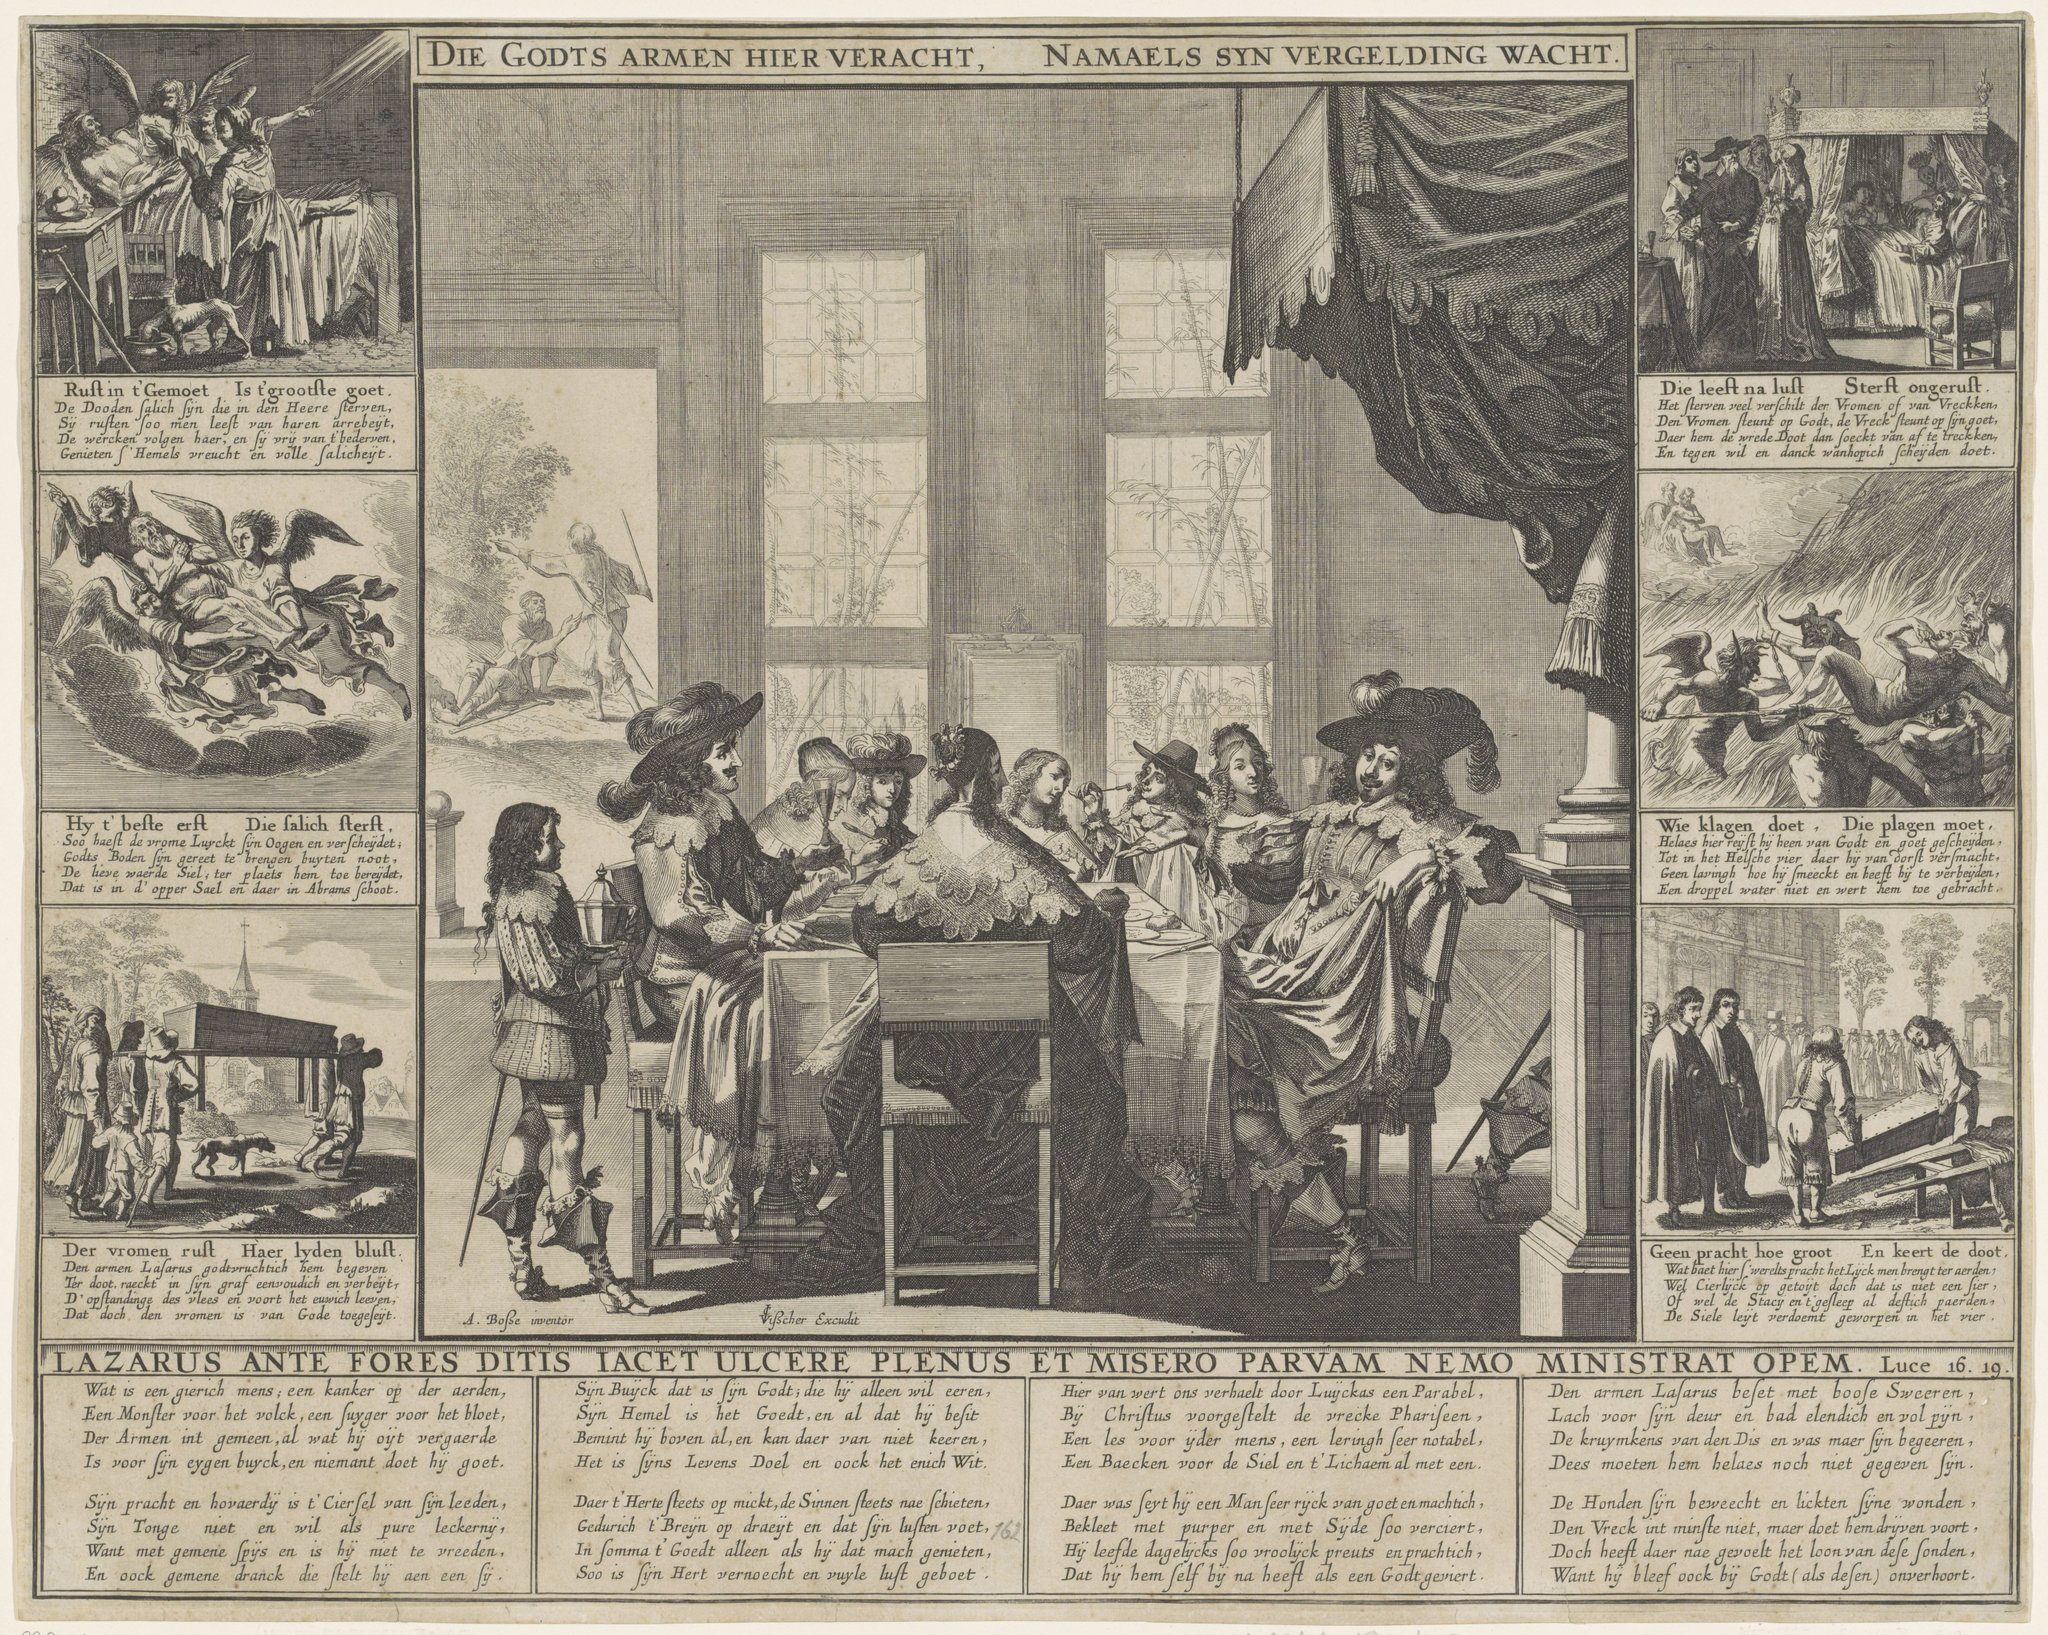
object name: print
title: Lazarus en de rijke man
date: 1630-1652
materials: paper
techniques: engraving, etching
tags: lazarus dies: his soul is carried into abraham's lap by angels, dives dies; his soul is brought into hell by devils, in hell dives sees lazarus in paradise; usually dives pointing at his tongue, the rich man (dives) is feasting, while poor lazarus is starving at the gate (dogs licking lazarus' sores) (luke 16:19-31)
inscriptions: collector's mark: Lugt 2228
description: De Amsterdamse uitgever Claes Jansz. Visscher (II) produceerde vanaf de jaren ’30 van de zeventiende eeuw grote Bijbelse prenten op zogenaamd royaal-formaat papier (ca. 480 x 580 mm). Na zijn dood in 1652 zette zijn zoon Nicolaes Visscher (I) het bedrijf voort en zo ook de uitgave van Royaalbijbelprenten. Toen Nicolaes in 1679 overleed nam zijn zoon Nicolaes Visscher (II) het bedrijf over en gaf kort hierna, omstreeks 1680, een fondslijst uit. Hierin worden 130 prenten met Bijbelse voorstellingen op royaalpapier beschreven (zie documentatie J. van der Waals). Complete prentbijbels op royaal-formaat werden door vader en zoon Nicolaes Visscher uitgegeven onder de titel Historiae Sacrae Veteris et Novi Testamenti. De bladen werden echter ook los verkocht en konden worden gecombineerd met Royaalbijbel-prenten van andere uitgevers. Verschillende Amsterdamse uitgevers brachten namelijk ook bijbelprenten op royaal-formaat uit, onder wie Clement de Jonghe en Cornelis Danckerts. De door de firma Visscher uitgegeven prenten zijn veelal vervaardigd door anonieme prentmakers naar voorbeeld van verschillende zestiende- en zeventiende-eeuwse Bijbelse prenten en prentreeksen. Veelal moesten de composities worden aangepast aan het grotere en langgerekte royaal-formaat. Daarnaast zijn er ook grote bladen van bekende prentmakers zoals Jan van Londerseel, Pieter Nolpe, Jacques de Gheyn (II) en Jan Harmensz. Muller opgenomen in de categorie ‘Bybelsche Figuren, op Royaal-bladen’ in de fondslijst van Visscher. Prent mogelijk gebruikt in: Historiae Sacrae Veteris et Novi Testamenti (Royaalbijbel). Amsterdam: Nicolaes Visscher (I) en (II), [1652-1702]. In de fondslijst van Nicolaes Visscher II (ca. 1680) is het onderwerp van deze prent onder de titel 'Bybelsche Figuren, op Royaal-bladen. bestaande uyt de volgende historien.' als volgt genummerd: 90.